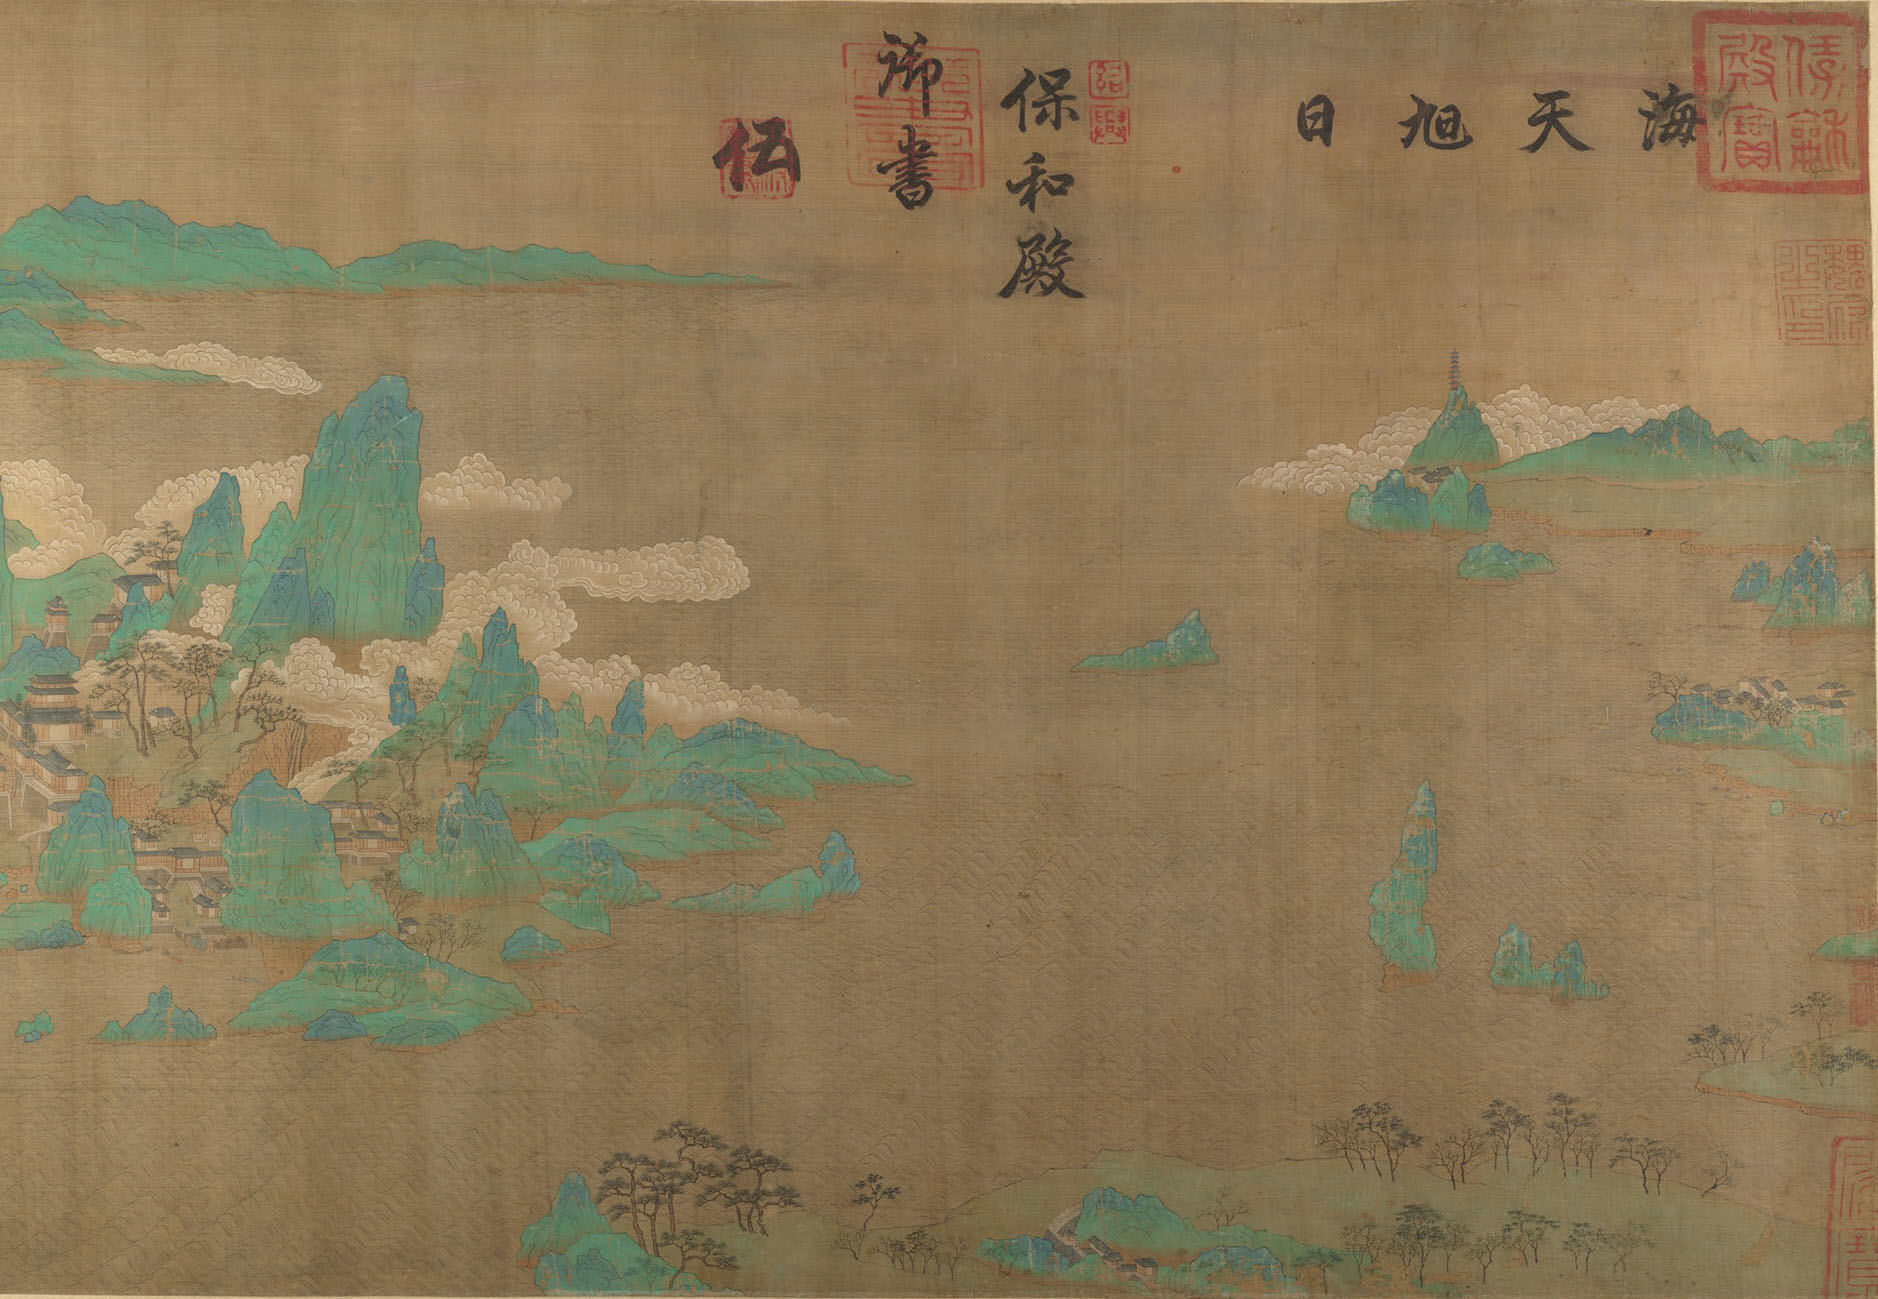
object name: handscroll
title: Sea and Sky at Sunrise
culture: chinese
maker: unidentified artist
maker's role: artist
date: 1601-1700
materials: ink, silk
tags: trees,seascapes